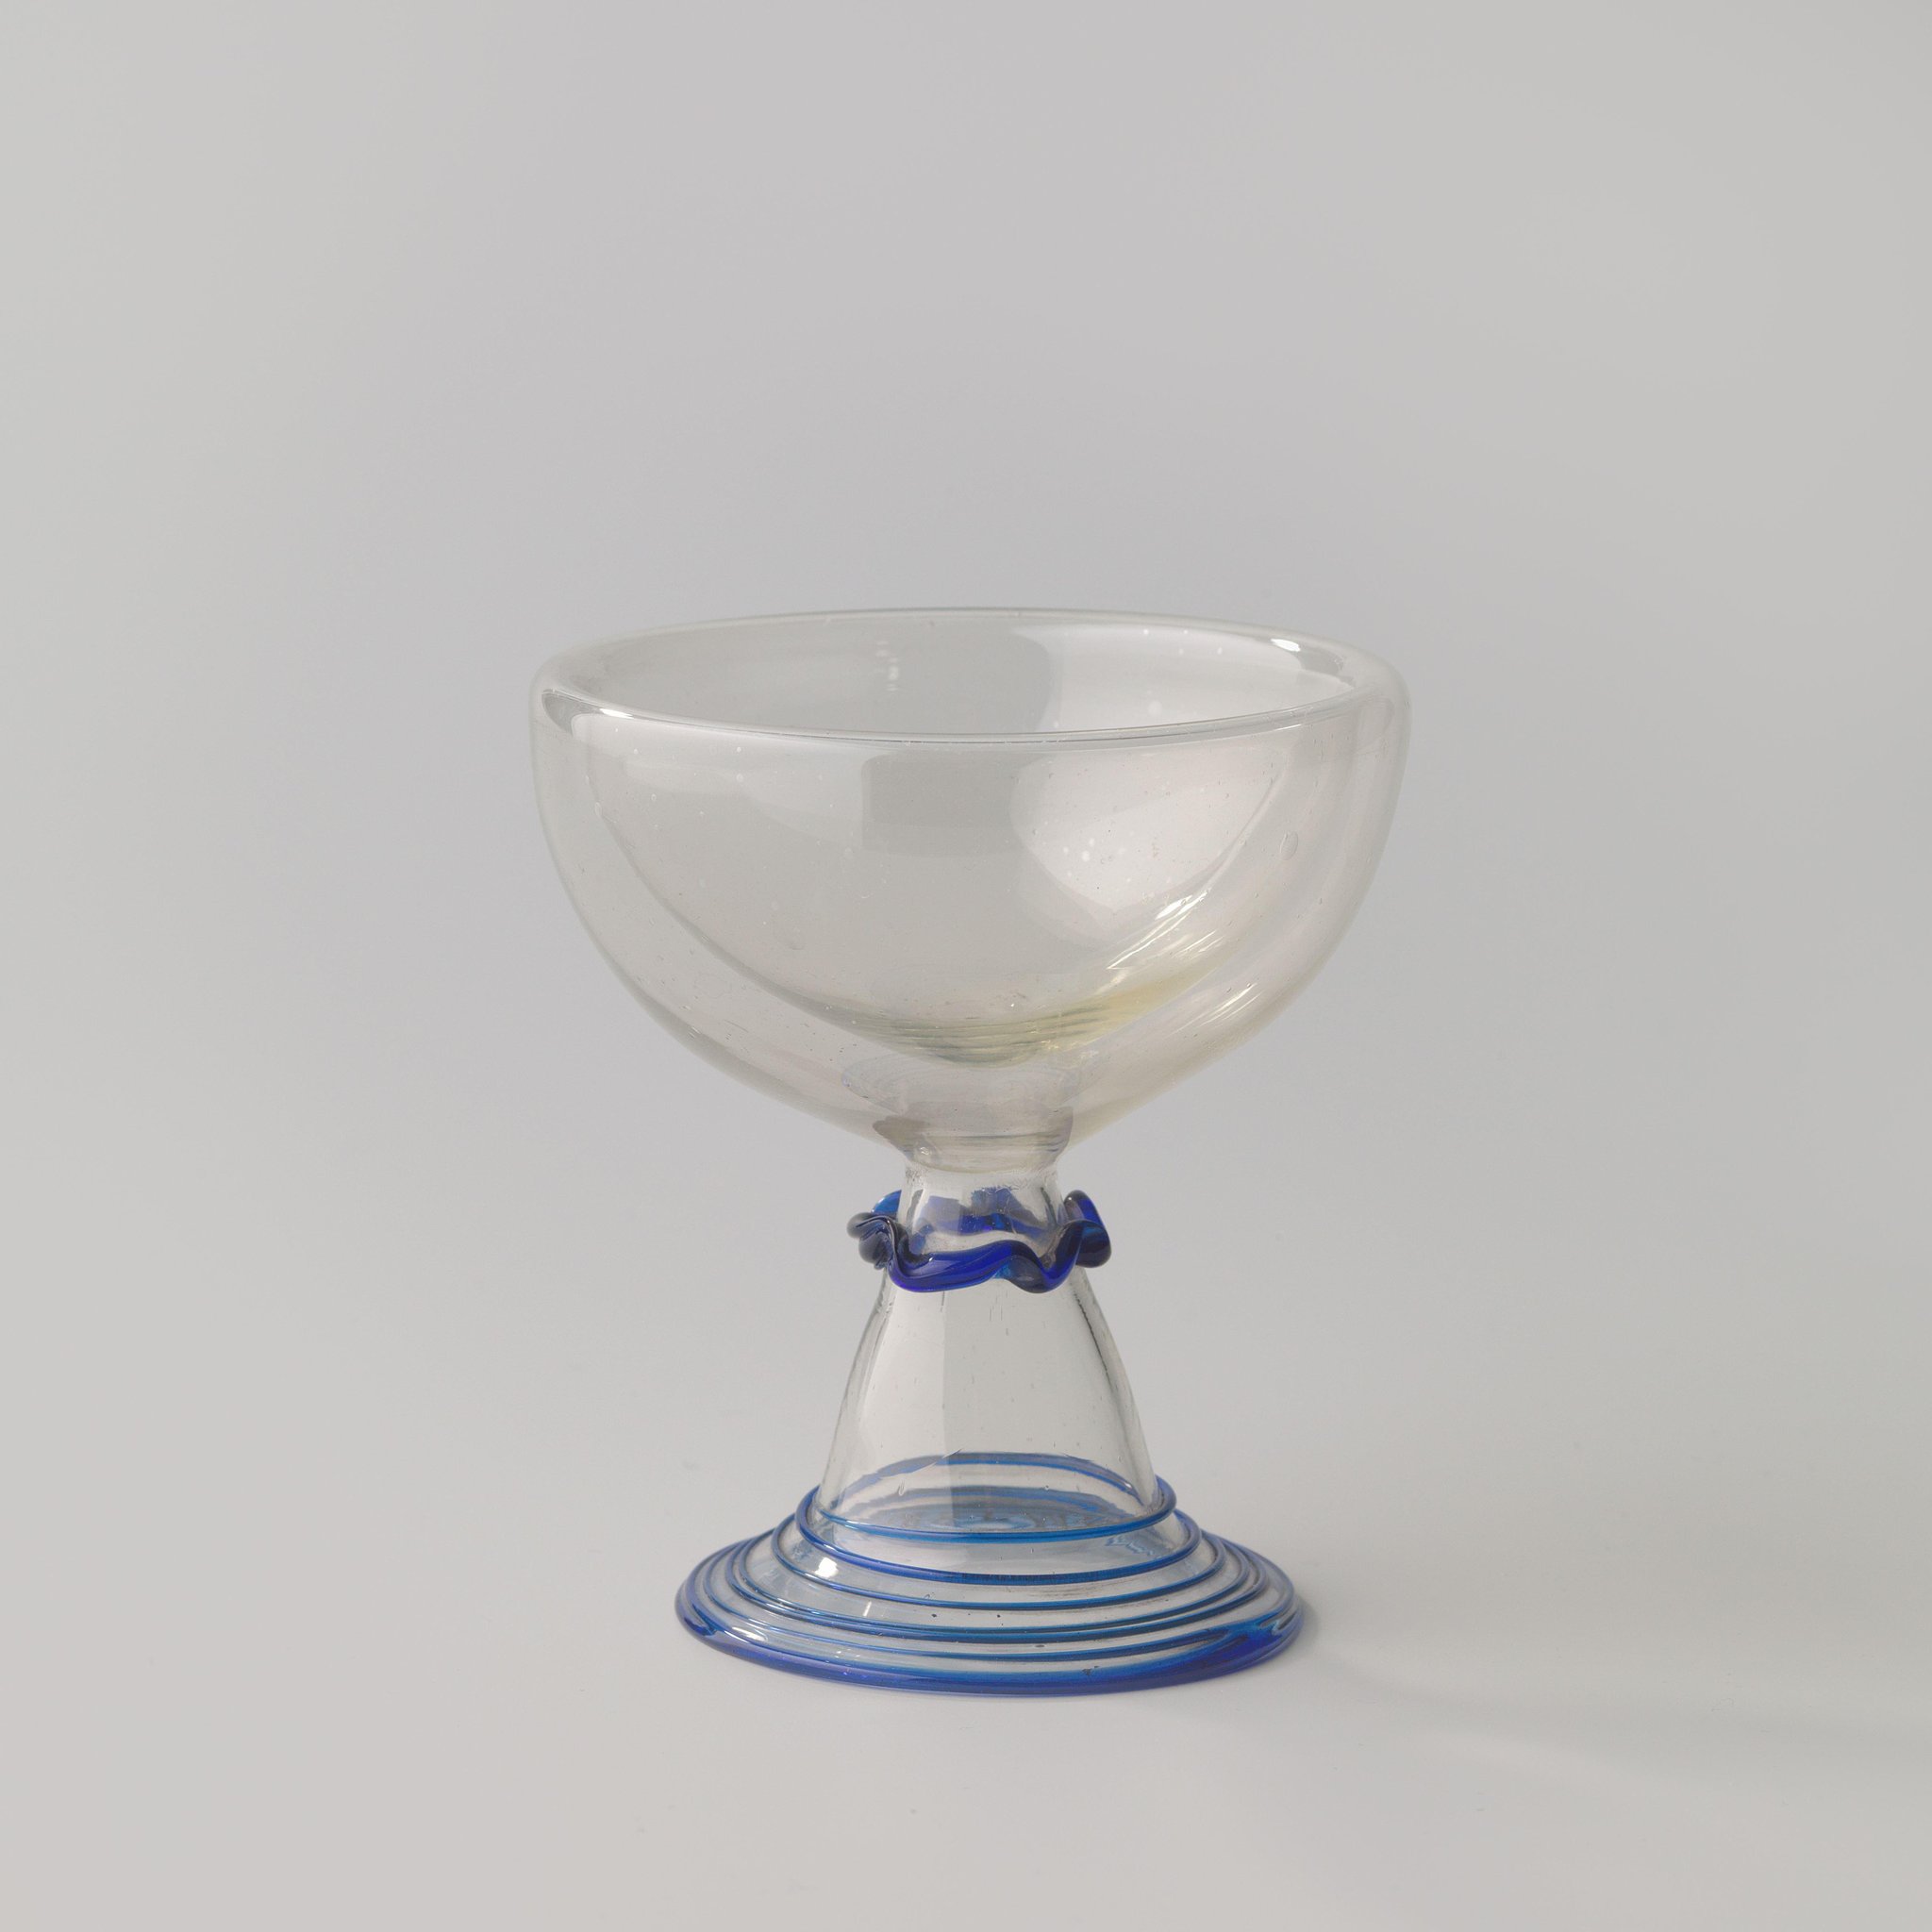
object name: salt condiment vessel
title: Zoutvat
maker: Anonymous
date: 1600-1700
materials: glass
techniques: glassblowing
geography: venice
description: Zoutvat op brede lage voet, overgaande in een conisch toelopende stam. De voet omslingerd met een gladde blauwe draad, om de stam een gegolfde blauwe draad. De half bolvormige kelk, in één stuk geblazen met de stam, is dubbelwandig door het instulpen van de bovenzijde